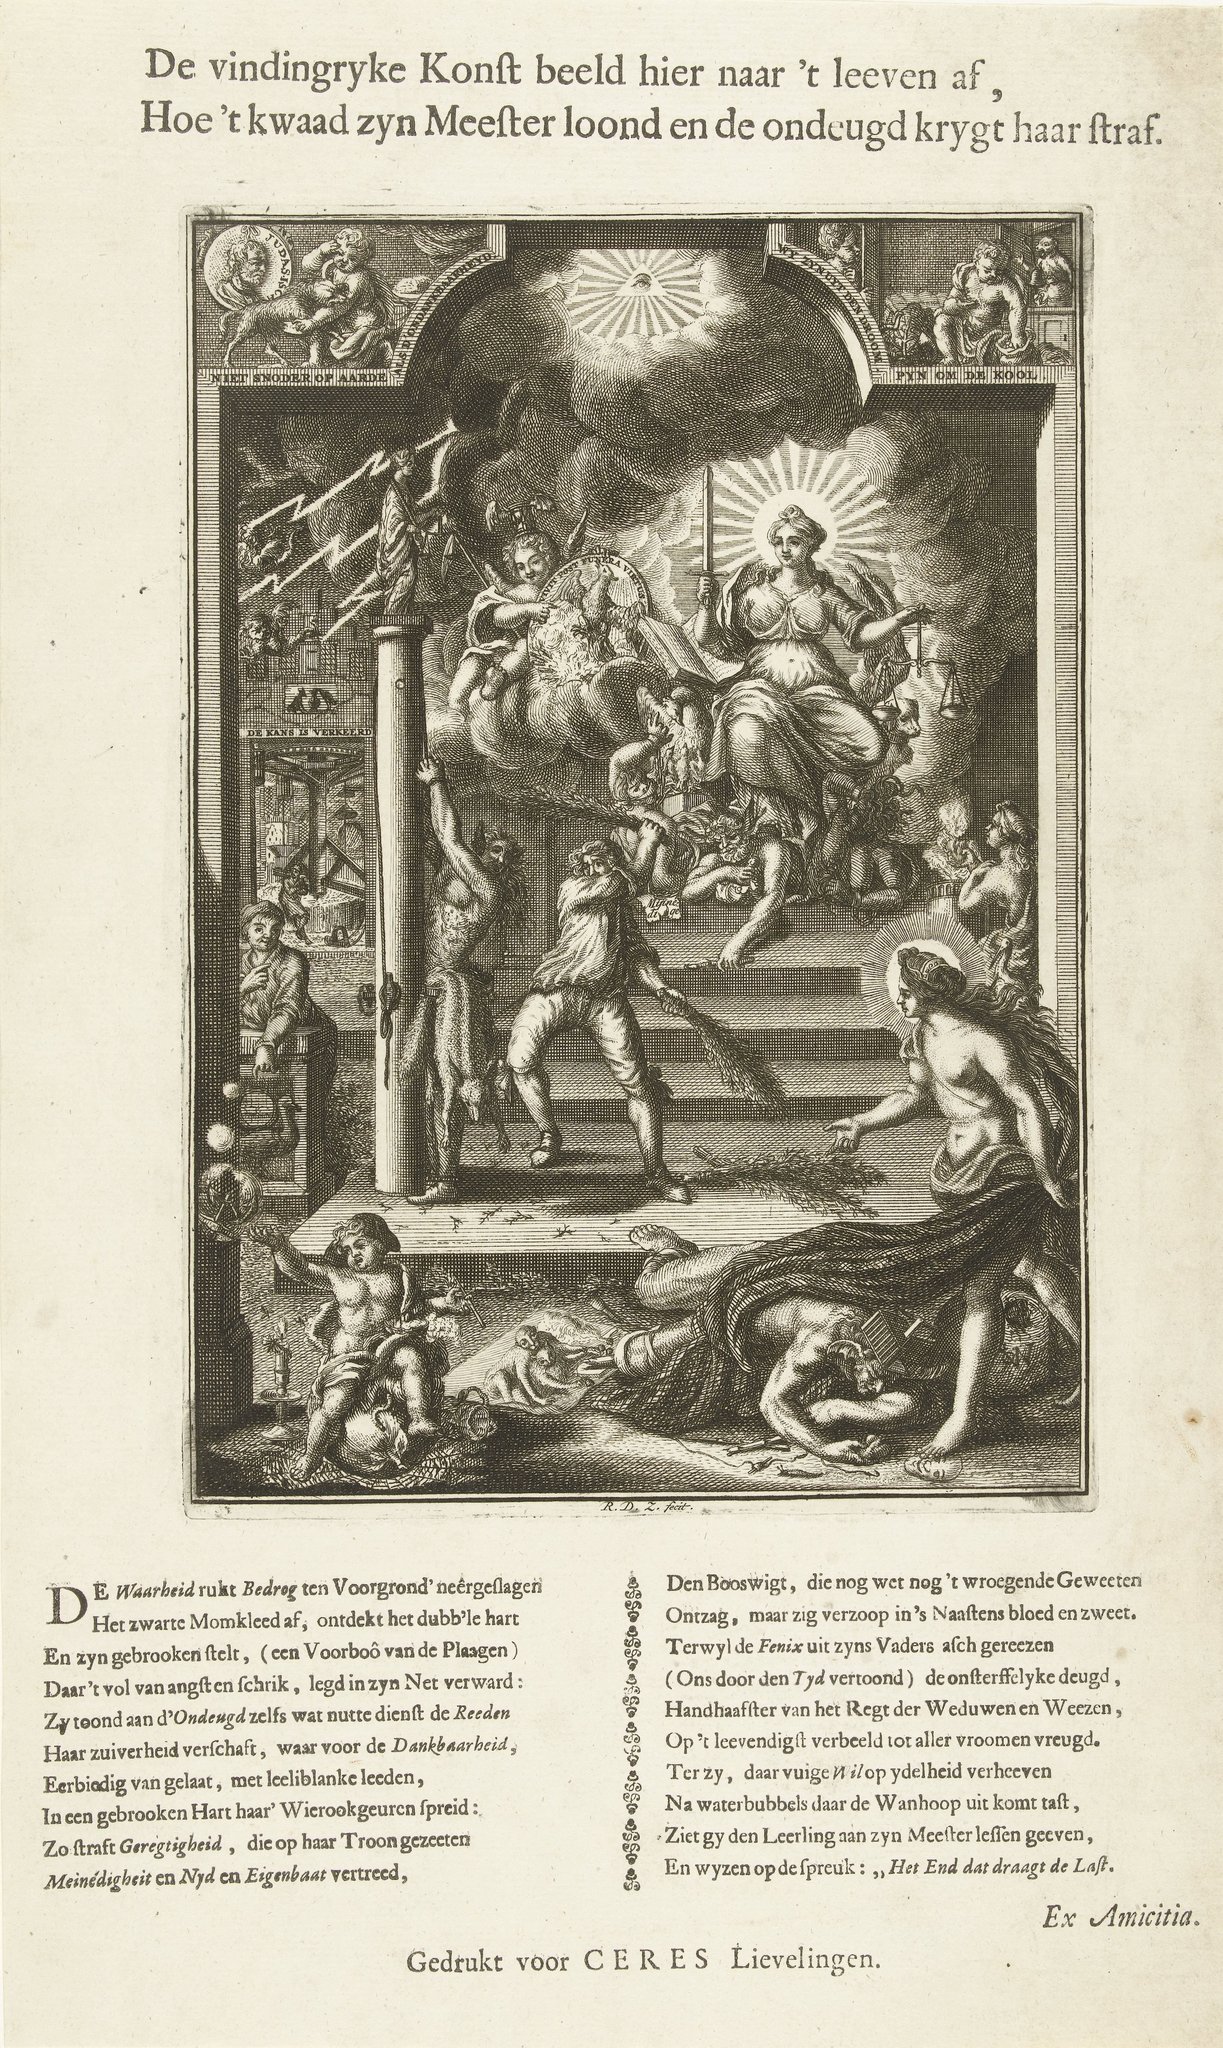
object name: print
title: De vindingryke Konst beeld hier naar 't leeven af, Hoe 't kwaad zyn Meester loond en de ondeugd krygt haar straf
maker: monogrammist rdz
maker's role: print maker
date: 1737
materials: paper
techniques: engraving, etching, letterpress printing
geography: northern netherlands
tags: amsterdam, torture, instruments of torture, execution or punishment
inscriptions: collector's mark: Lugt 2228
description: Allegorie waarin een man met een vossenvel om zijn middel (de Amsterdamse joodse bedrieger Aron Abrams of Abrahams) wordt gegeseld. Op de achtergrond de Gerechtigeheid, op de voorgrond onthult de Waarheid het Bedrog. Op het blad onder de plaat in het onderschrift een vers in twee kolommen.